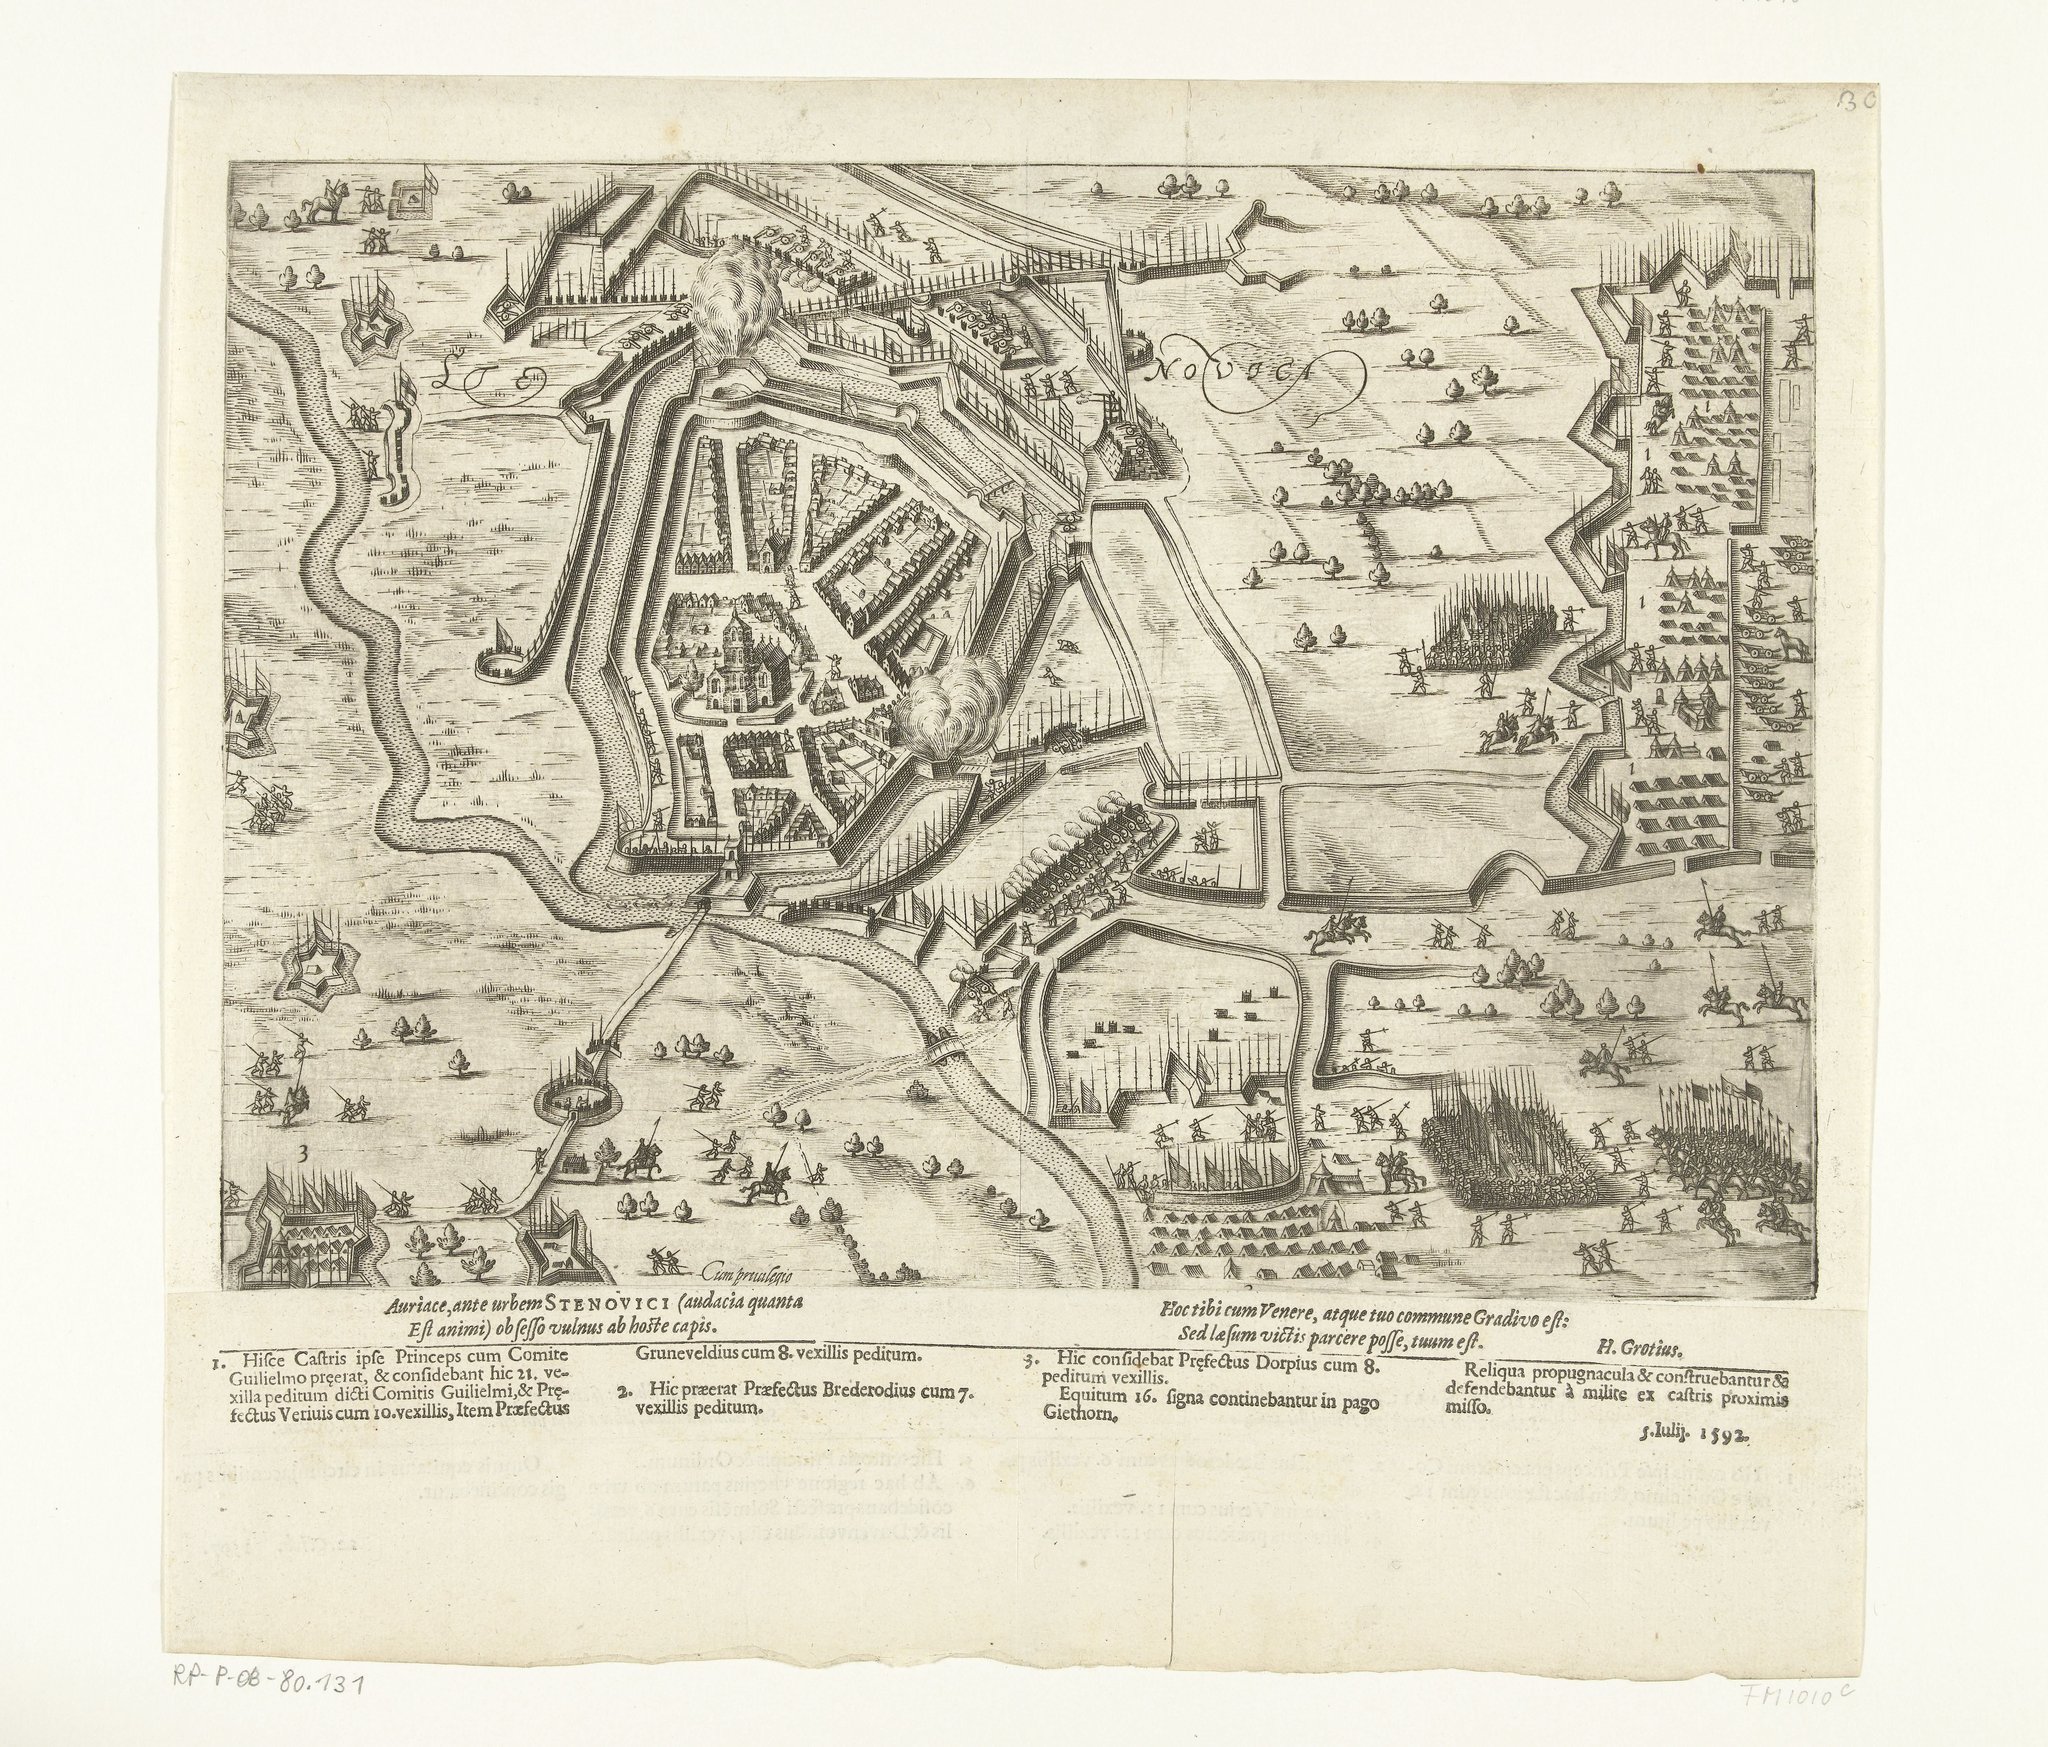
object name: print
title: Beleg van Steenwijk, 1592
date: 1600-1601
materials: paper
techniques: engraving, letterpress printing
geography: northern netherlands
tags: the hague, maurice (prince of orange), siege, position war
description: De plaat is later gebruikt als illustratie in: J.J. Orlers, Den Nassauschen Lauren-Crans: Beschrijvinghe ende af-beeldinge van alle de victorien ... die Godt Almachtich de ... Staten der Vereenichde Nederlanden verleent heeft, deur het wijs ende clouck beleyt des Hooch-ghebooren Fursts Maurits van Nassau, J.J. Orlers en H. van Haestens, Leiden 1610, fol. 84/85.